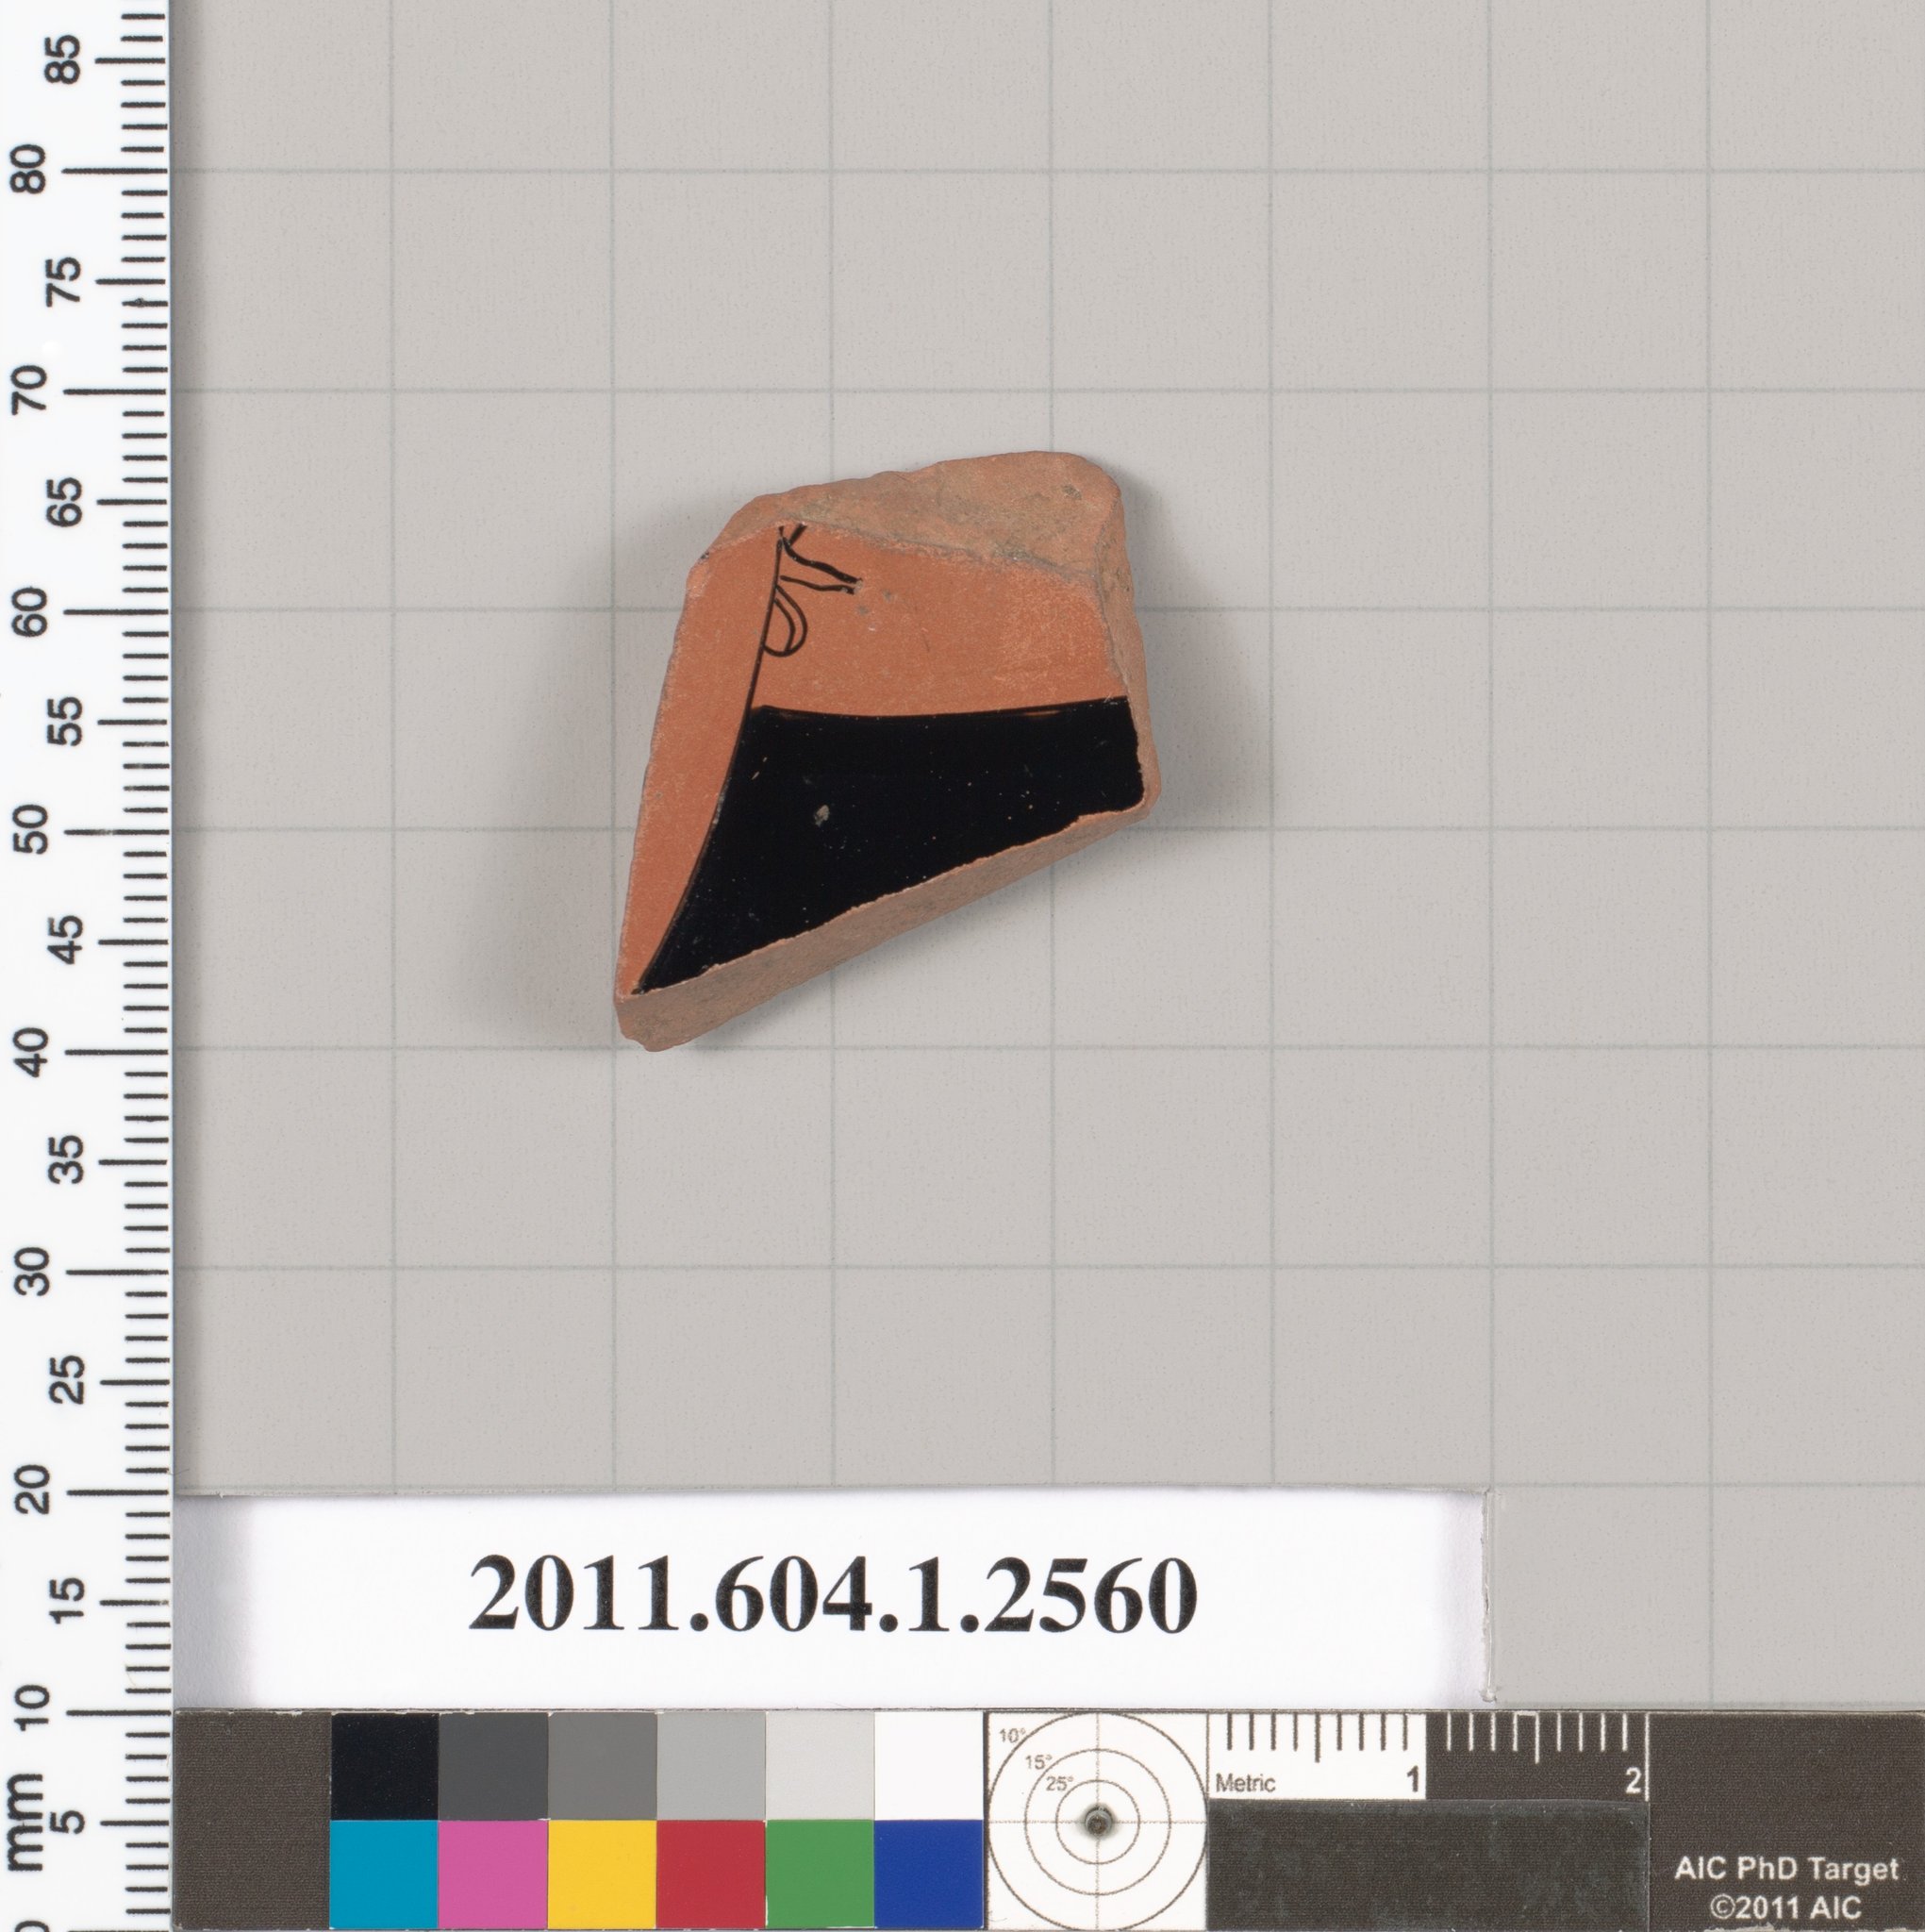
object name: kylix fragment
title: Terracotta fragment of a kylix (drinking cup)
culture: greek, attic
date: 490-480 BCE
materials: terracotta